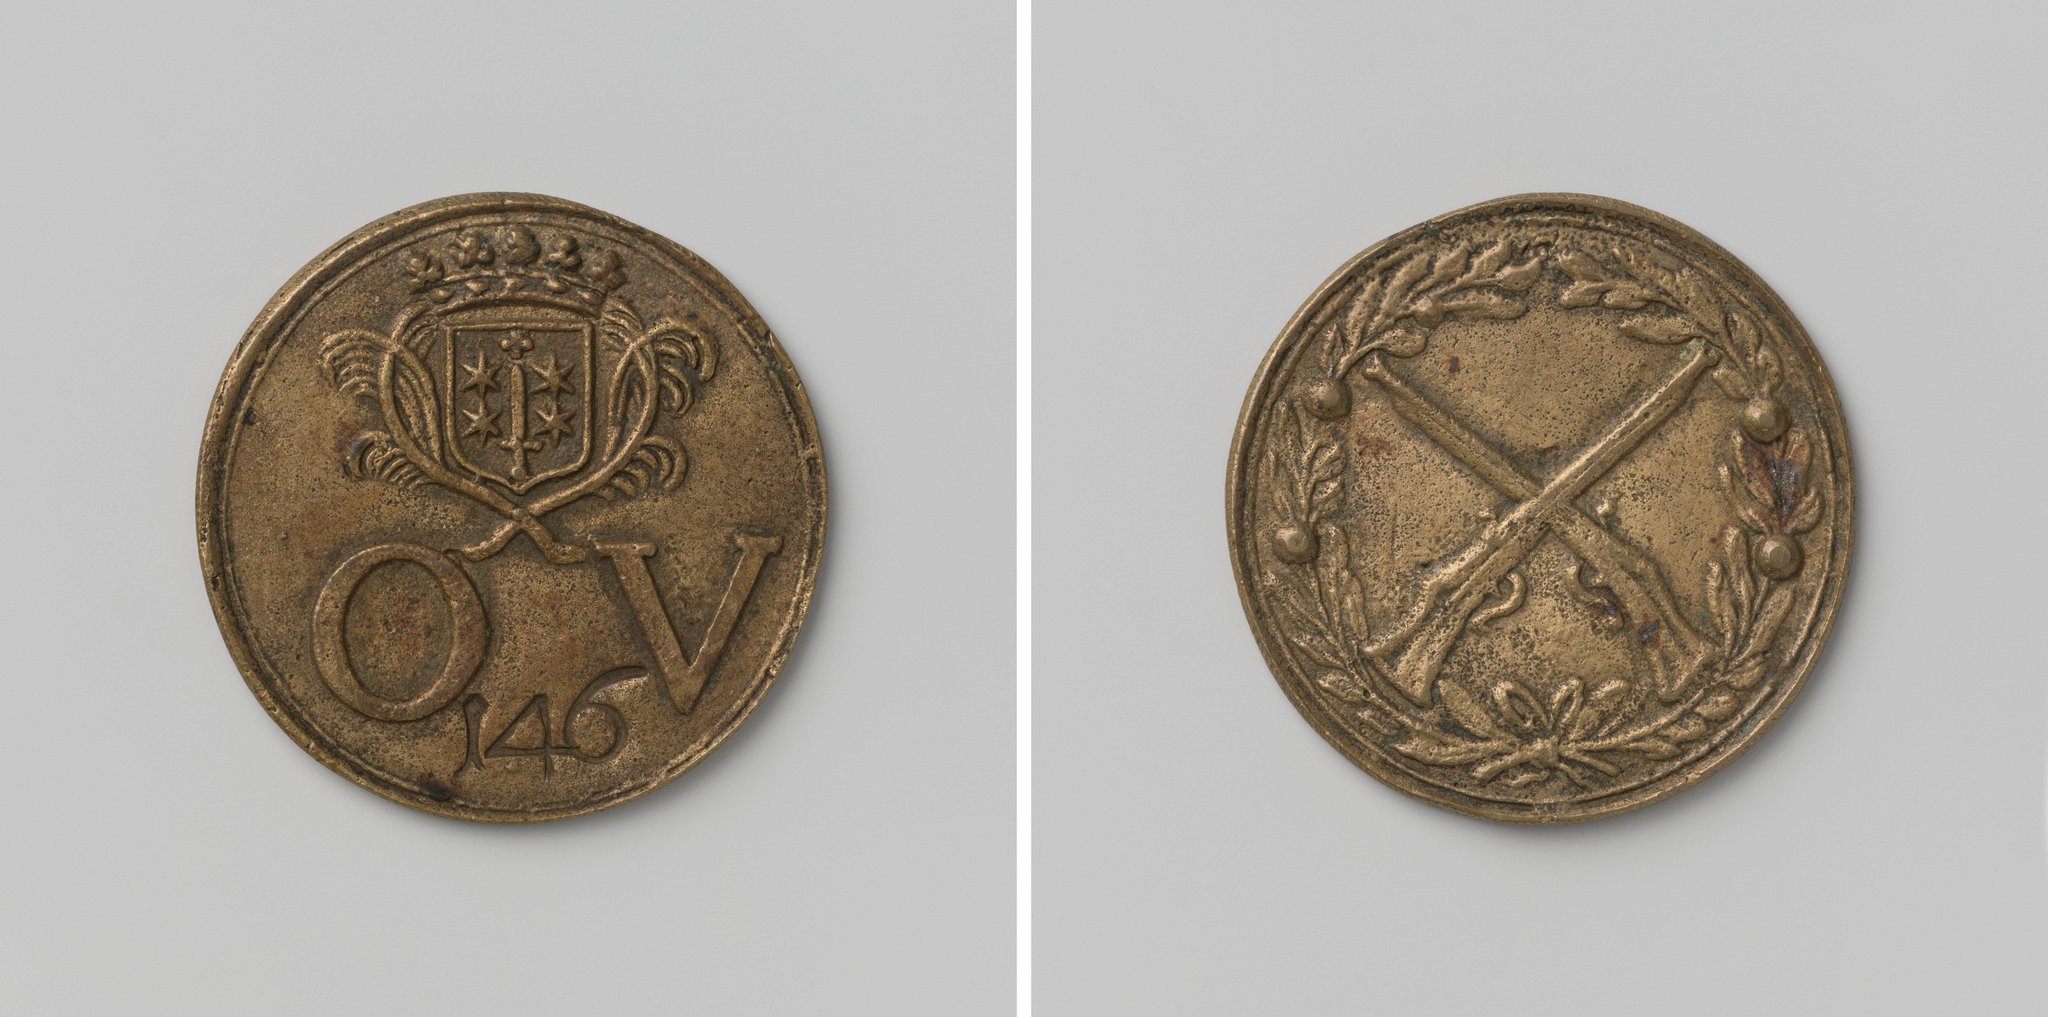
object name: marksman medal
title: Schutterij van Haarlem, schutterspenning van het Oranje Vaandel met no. 146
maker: Anonymous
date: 1650-1750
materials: brass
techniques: casting, engraving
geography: haarlem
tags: haarlem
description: Messing penning. Voorzijde: gekroond wapenschild op twee gekruiste palmtakken boven letters O en V; daartussen: cijfer 146. Keerzijde: twee gekruiste musketten binnen bladerkrans met vruchten